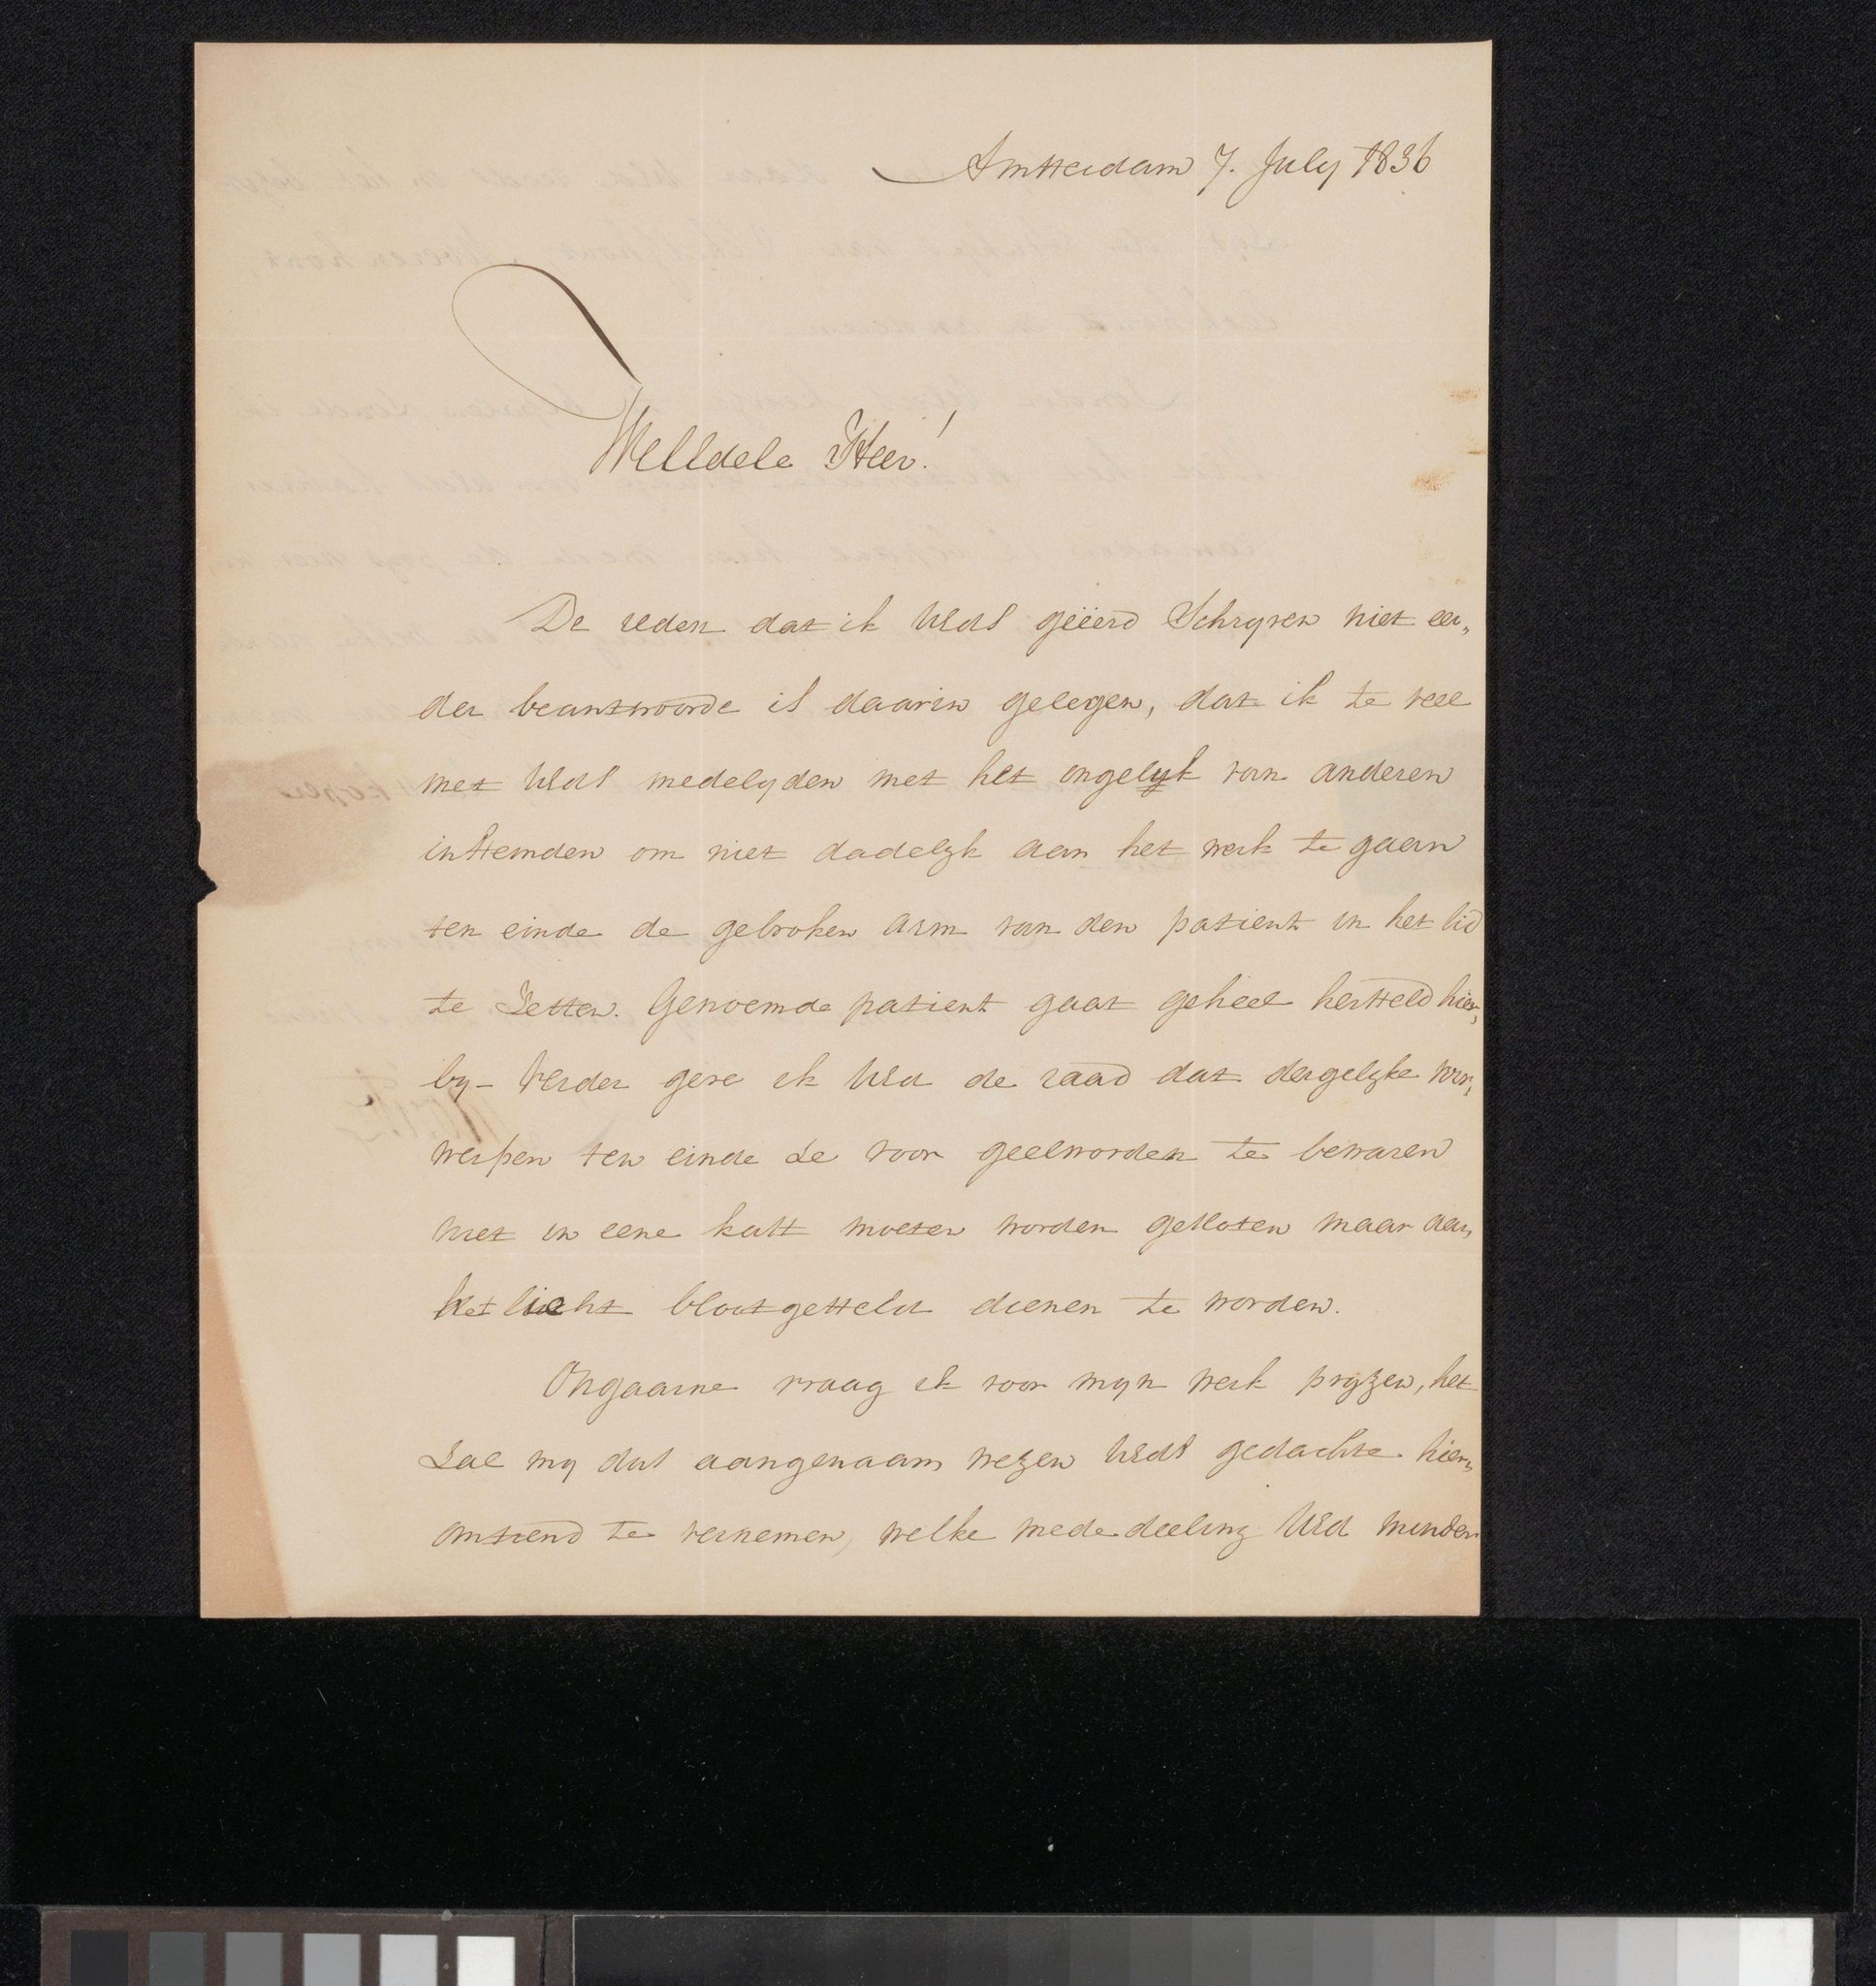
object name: letter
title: Brief aan Adrianus David Schinkel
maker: louis moritz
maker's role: draughtsman, painter, print maker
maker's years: 1773-1850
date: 1836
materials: ink, paper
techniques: pen, writing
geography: amsterdam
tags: andreas schelfhout, paris, jacob joseph eeckhout, painter, draughtsman, joseph moerenhout, printer, publisher, adrianus david schinkel, painting (including book-illumination, miniature-painting), art collecting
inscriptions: watermark